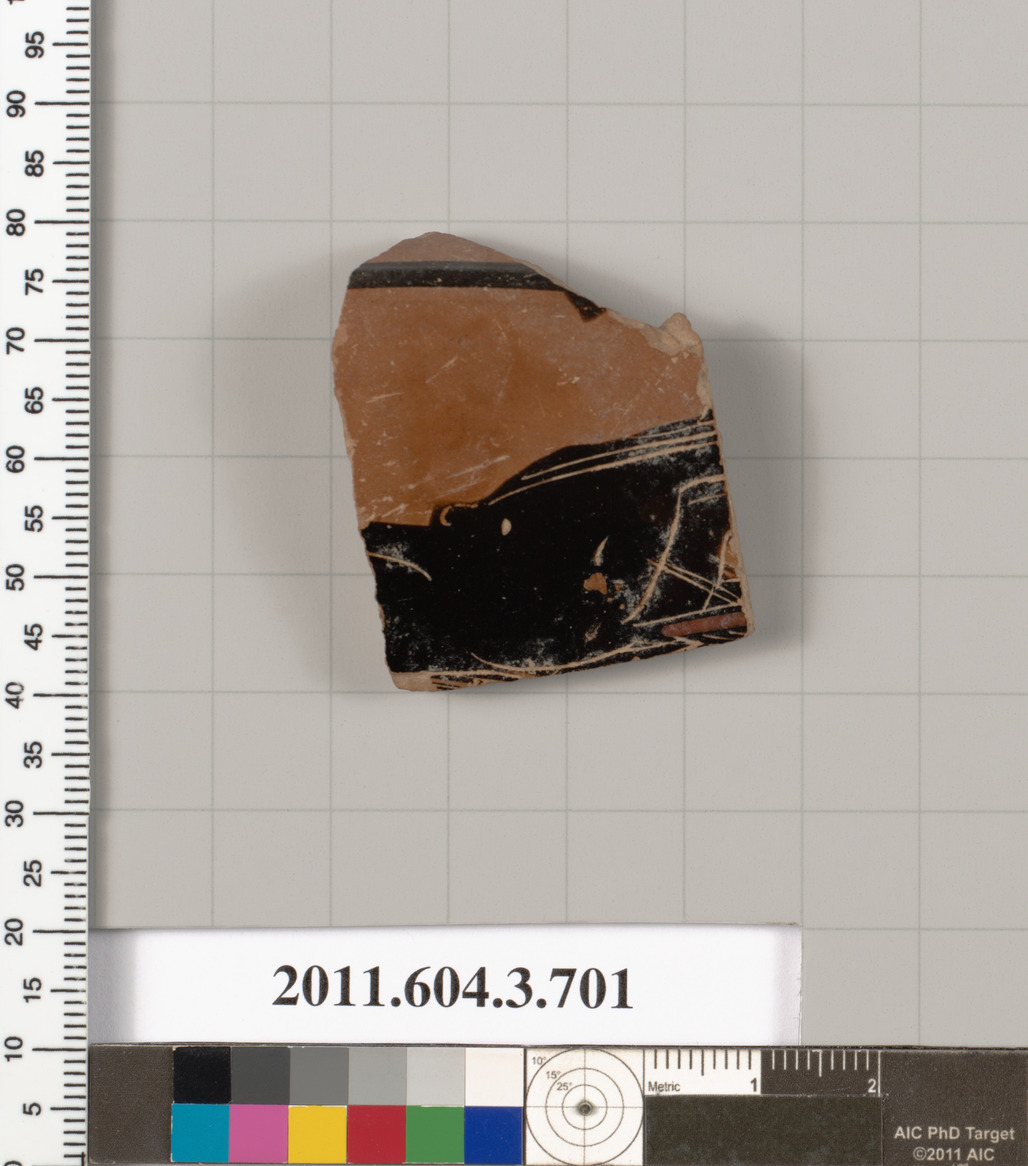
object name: hydria fragment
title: Terracotta fragment of a hydria (water jar)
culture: greek, attic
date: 600-501 BCE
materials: terracotta